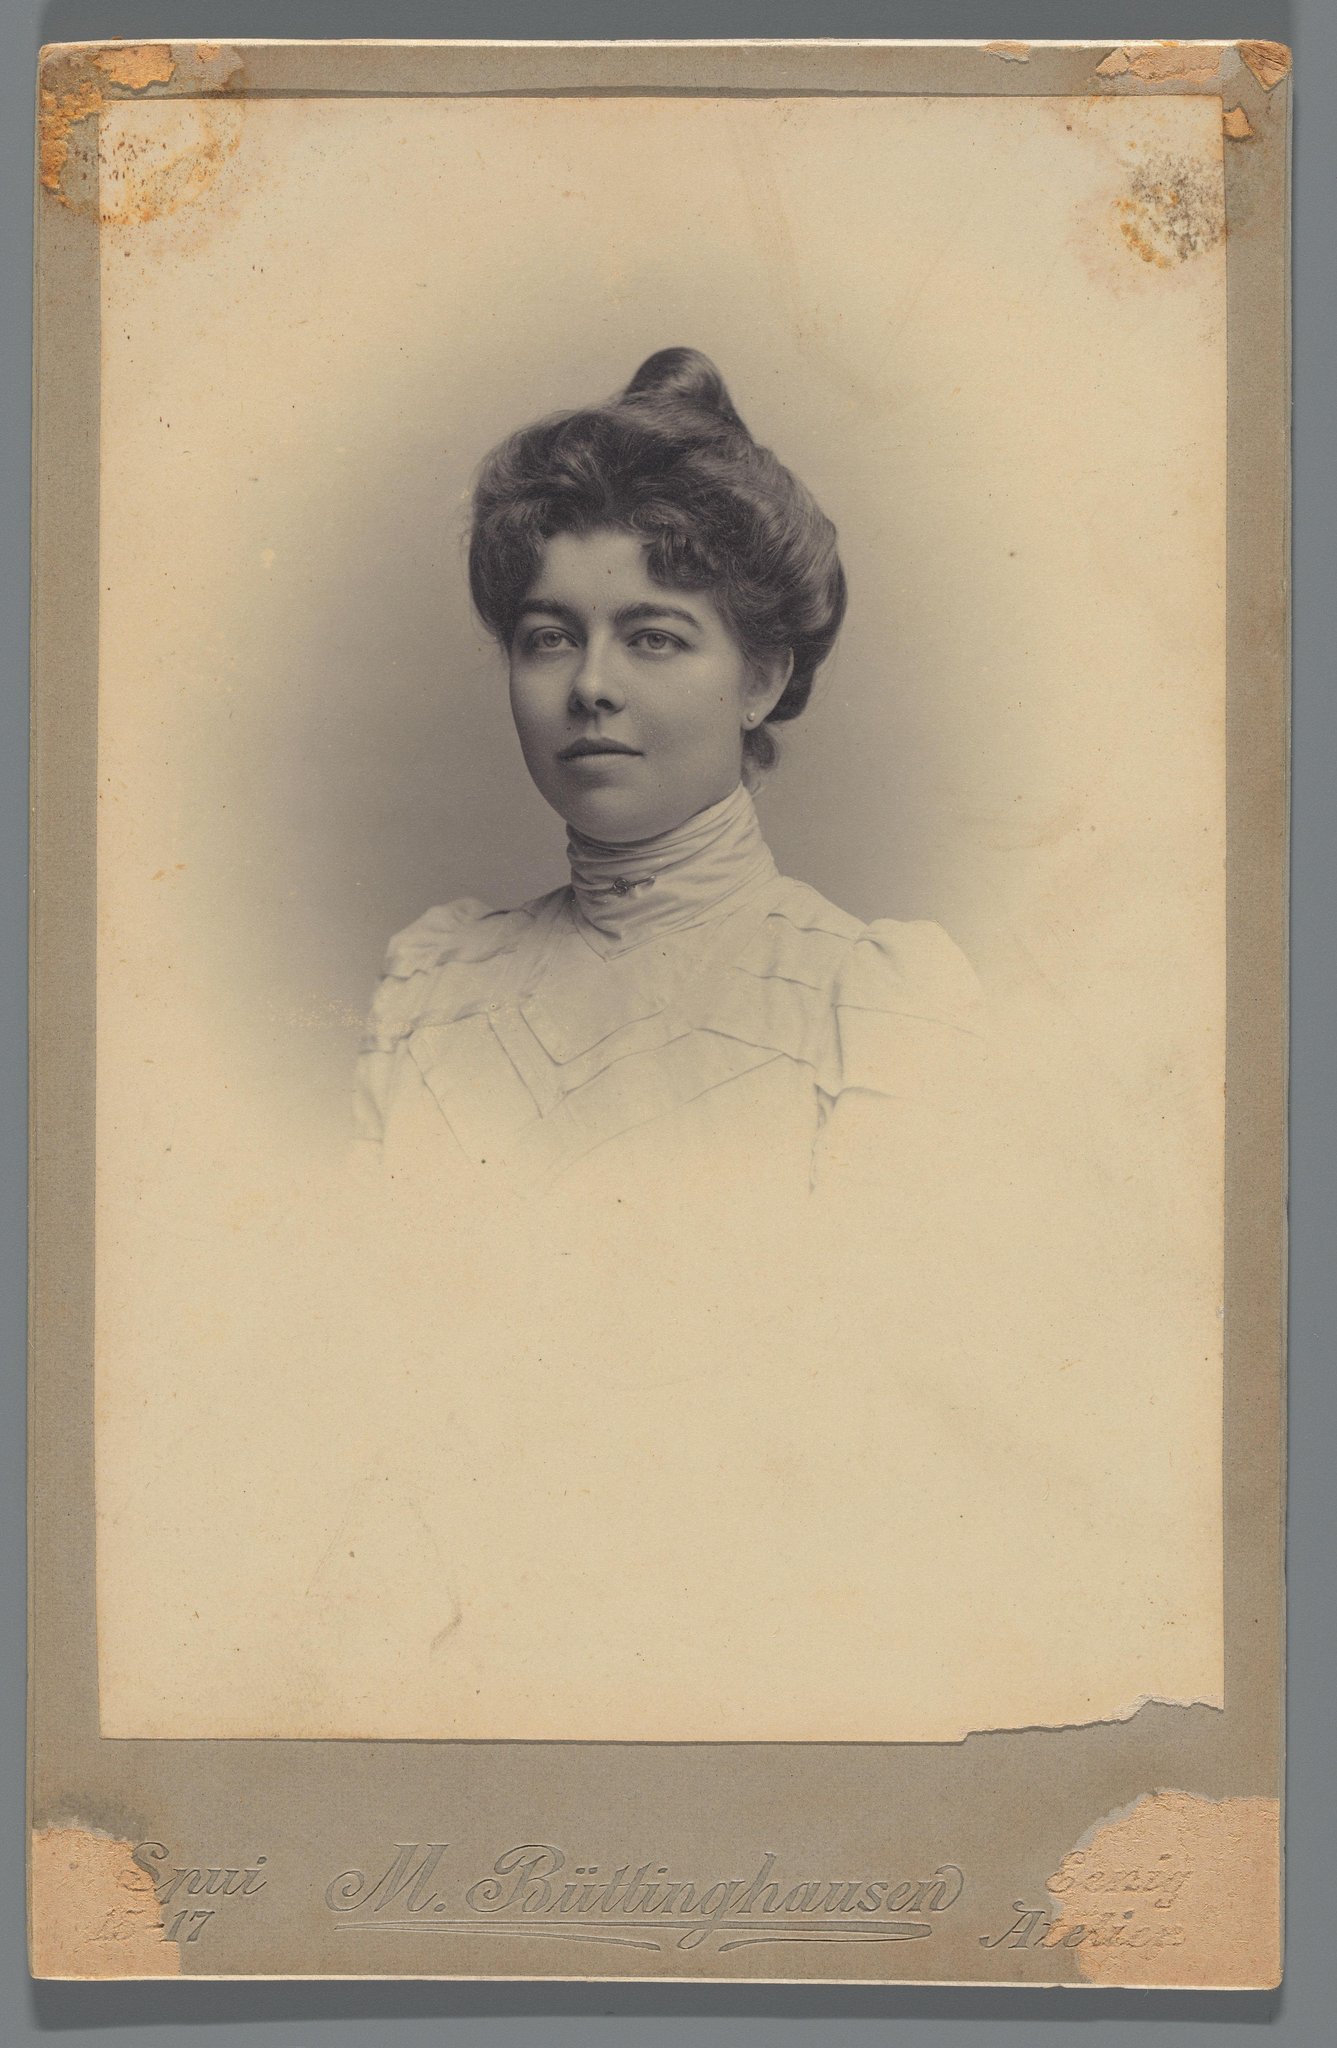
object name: cabinet photograph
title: Portret van A.C.M. Geertsema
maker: max büttinghausen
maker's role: fotograaf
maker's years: 1847-1906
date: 1870-1910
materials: cardboard, photographic support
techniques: albumen print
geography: spui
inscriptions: name, inscription: ‘Spui / 15 - 17 / M. Büttinghausen / Eenig / Atelier.’